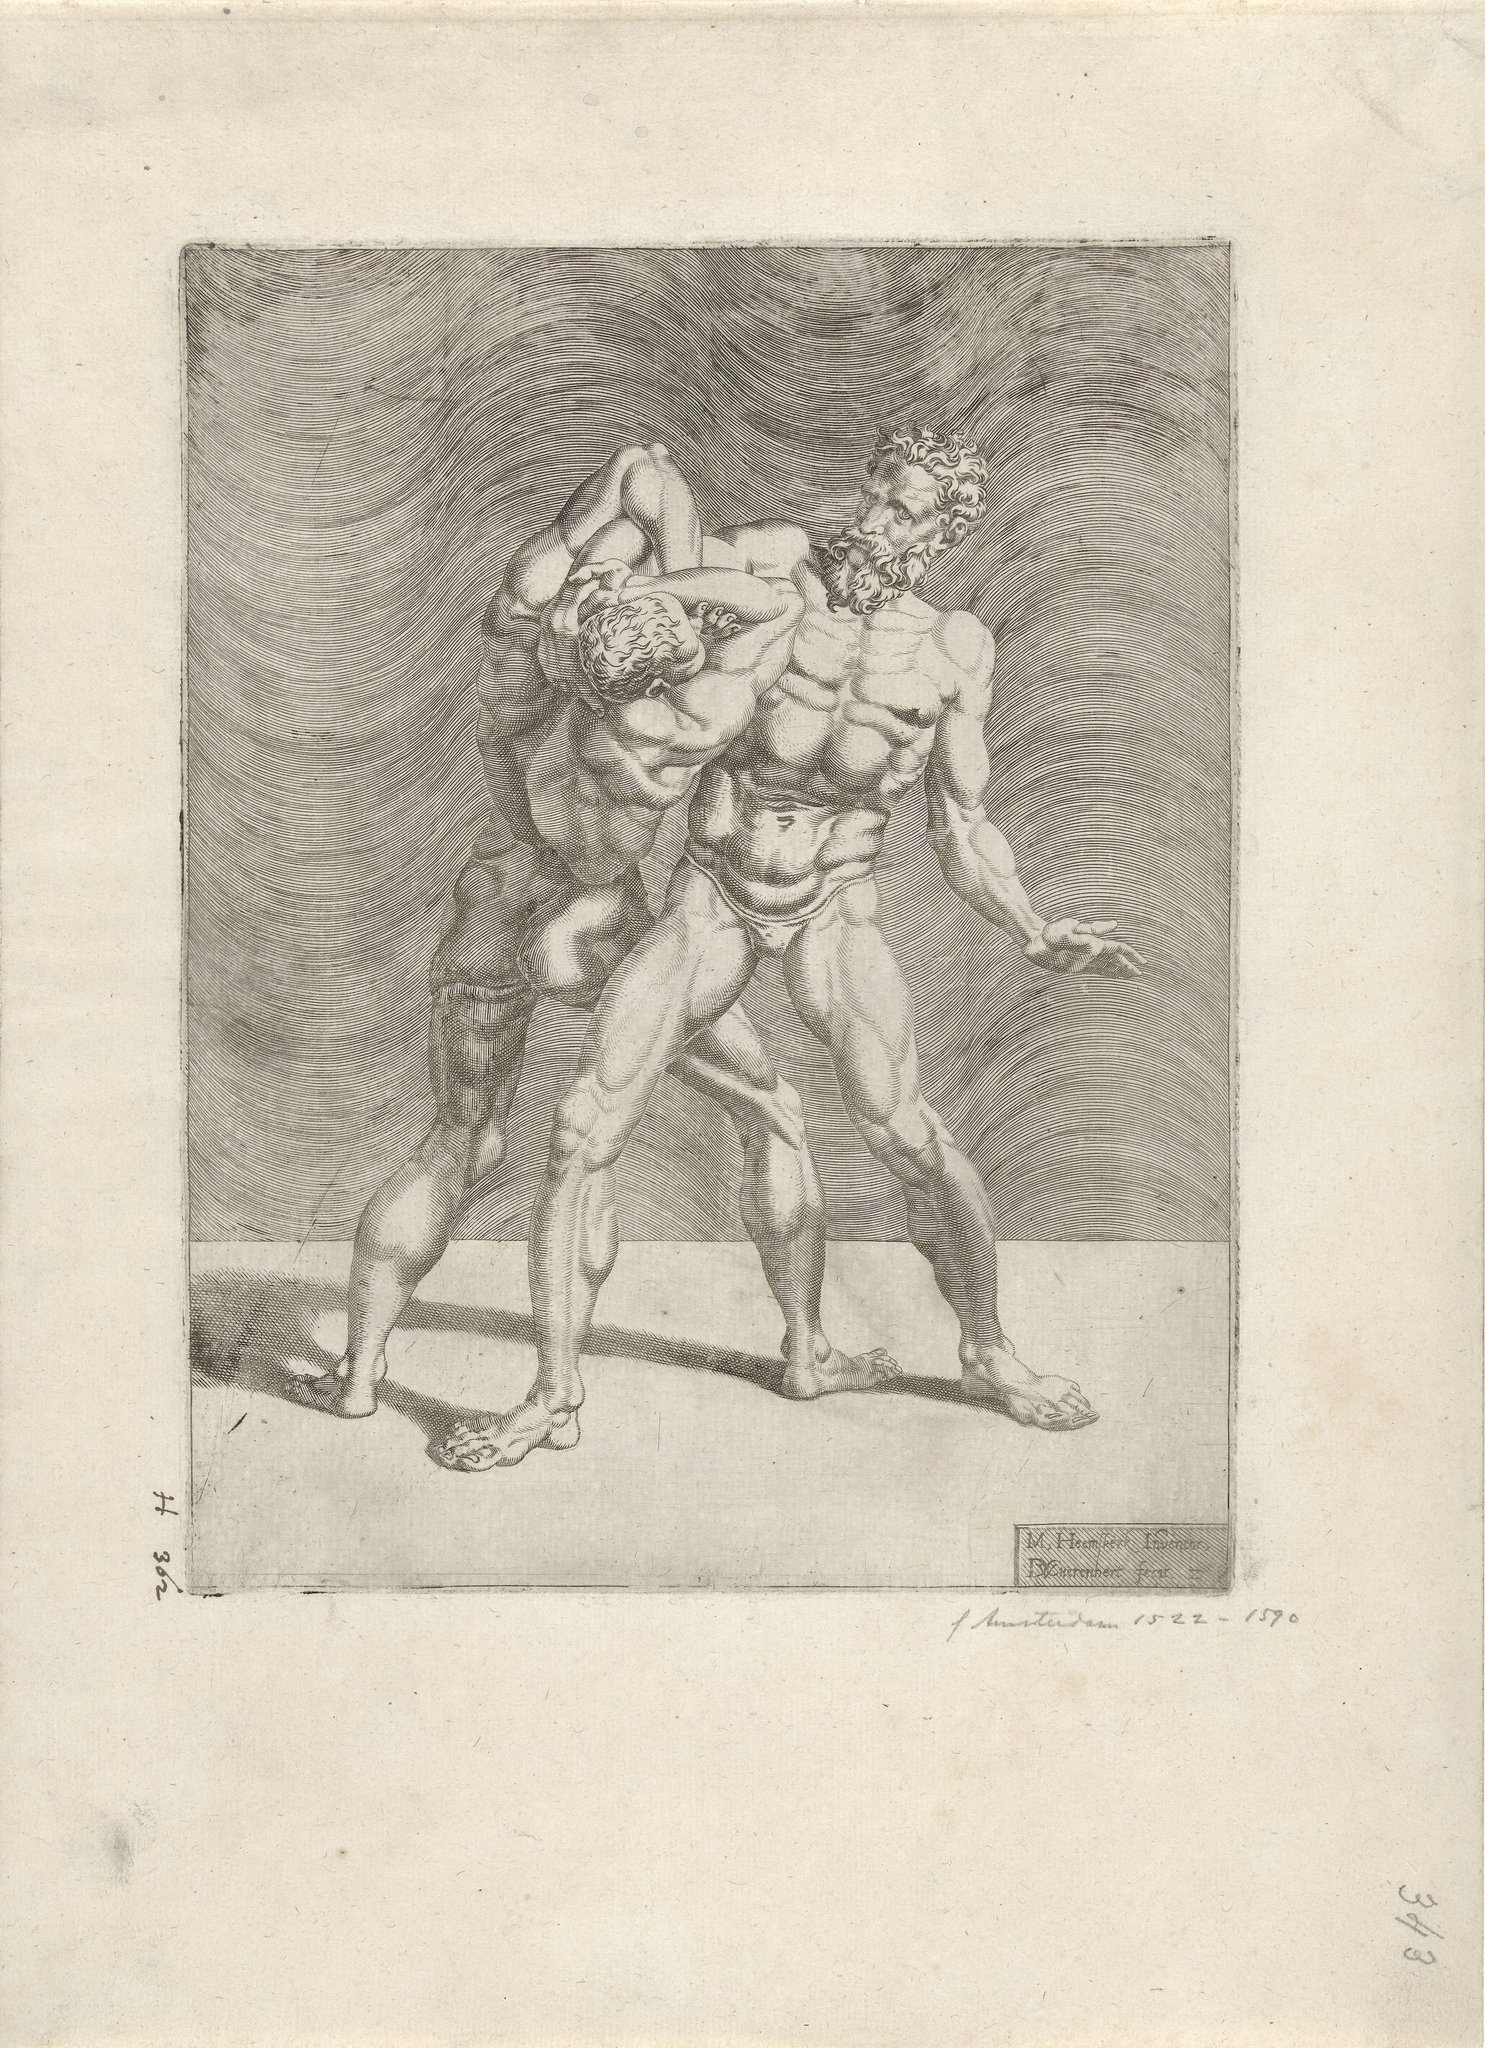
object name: print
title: Worstelaars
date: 1552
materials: paper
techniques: engraving, etching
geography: haarlem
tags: wrestling (sport)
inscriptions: collector's mark: Lugt 2760, collector's mark: Lugt 2228, number: ‘H.362’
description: Twee naakte worstelaars. De prent maakt deel uit van een serie over twee worstelaars in gevecht.